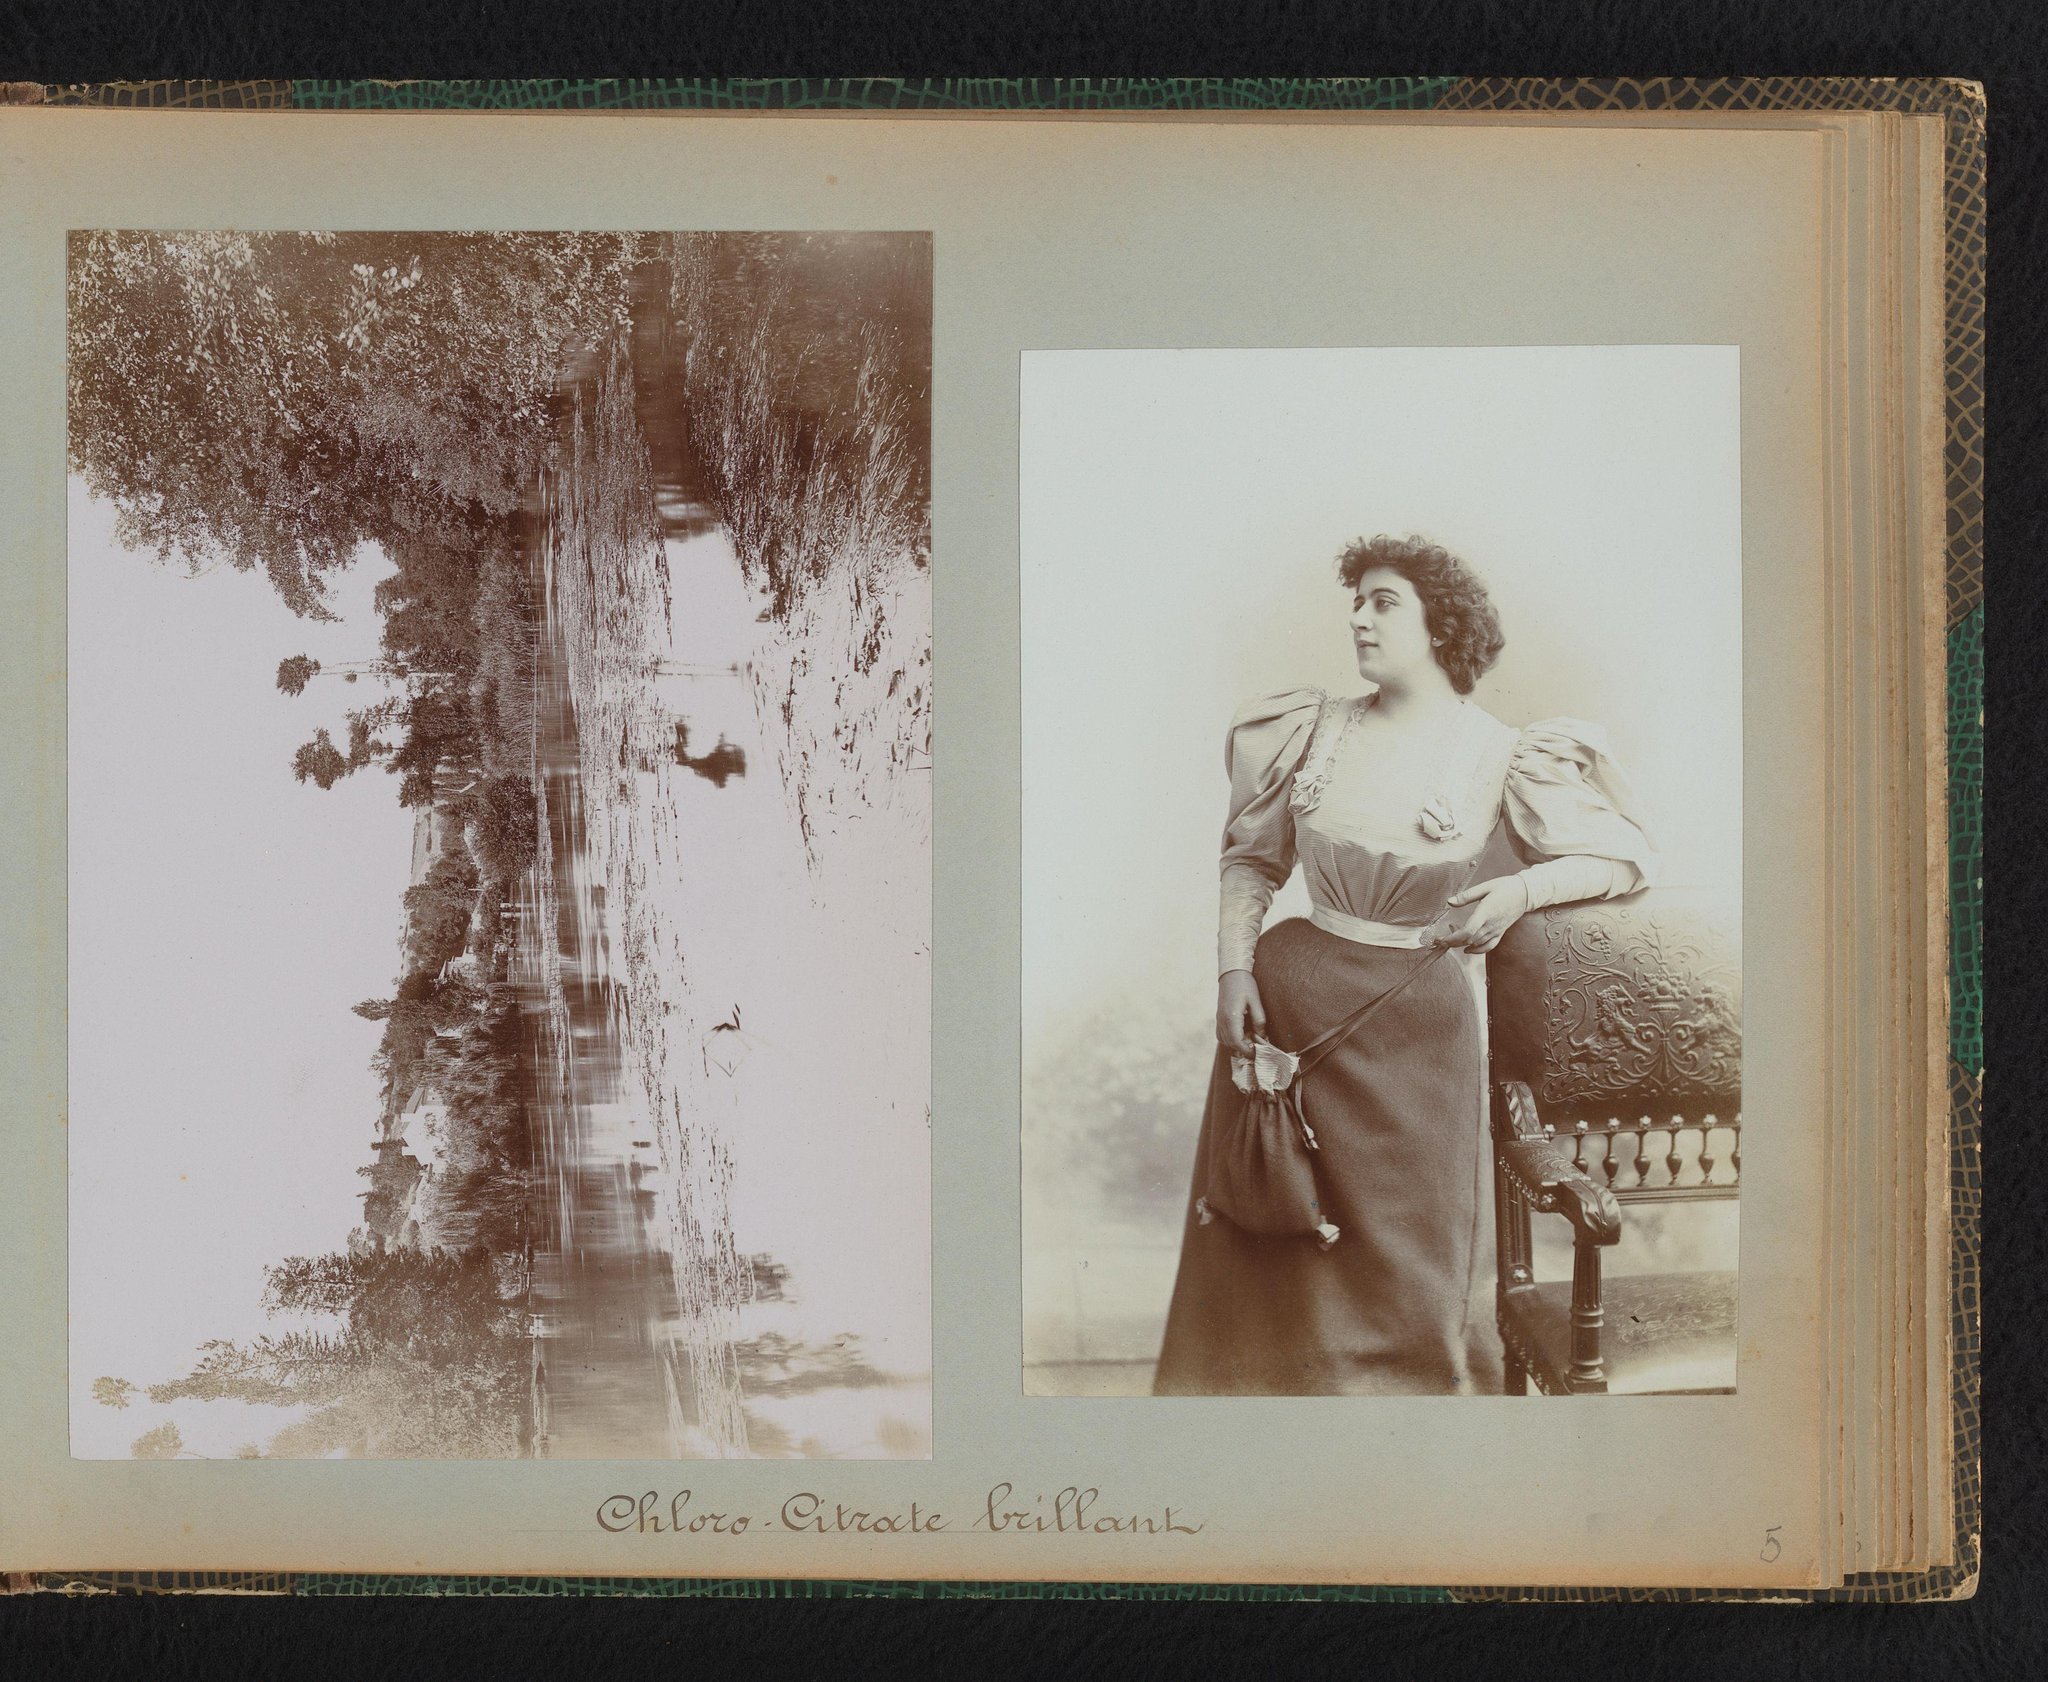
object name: photograph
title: Gezicht op een meer en een portret van een vrouw met buideltas leunend op een stoel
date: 1890-1910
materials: paper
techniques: gelatin silver print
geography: paris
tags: armchair, seat, bag, anonymous historical person portrayed alone - bb - woman, lake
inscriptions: inscription: ‘Chloro-Citrate brilliant’